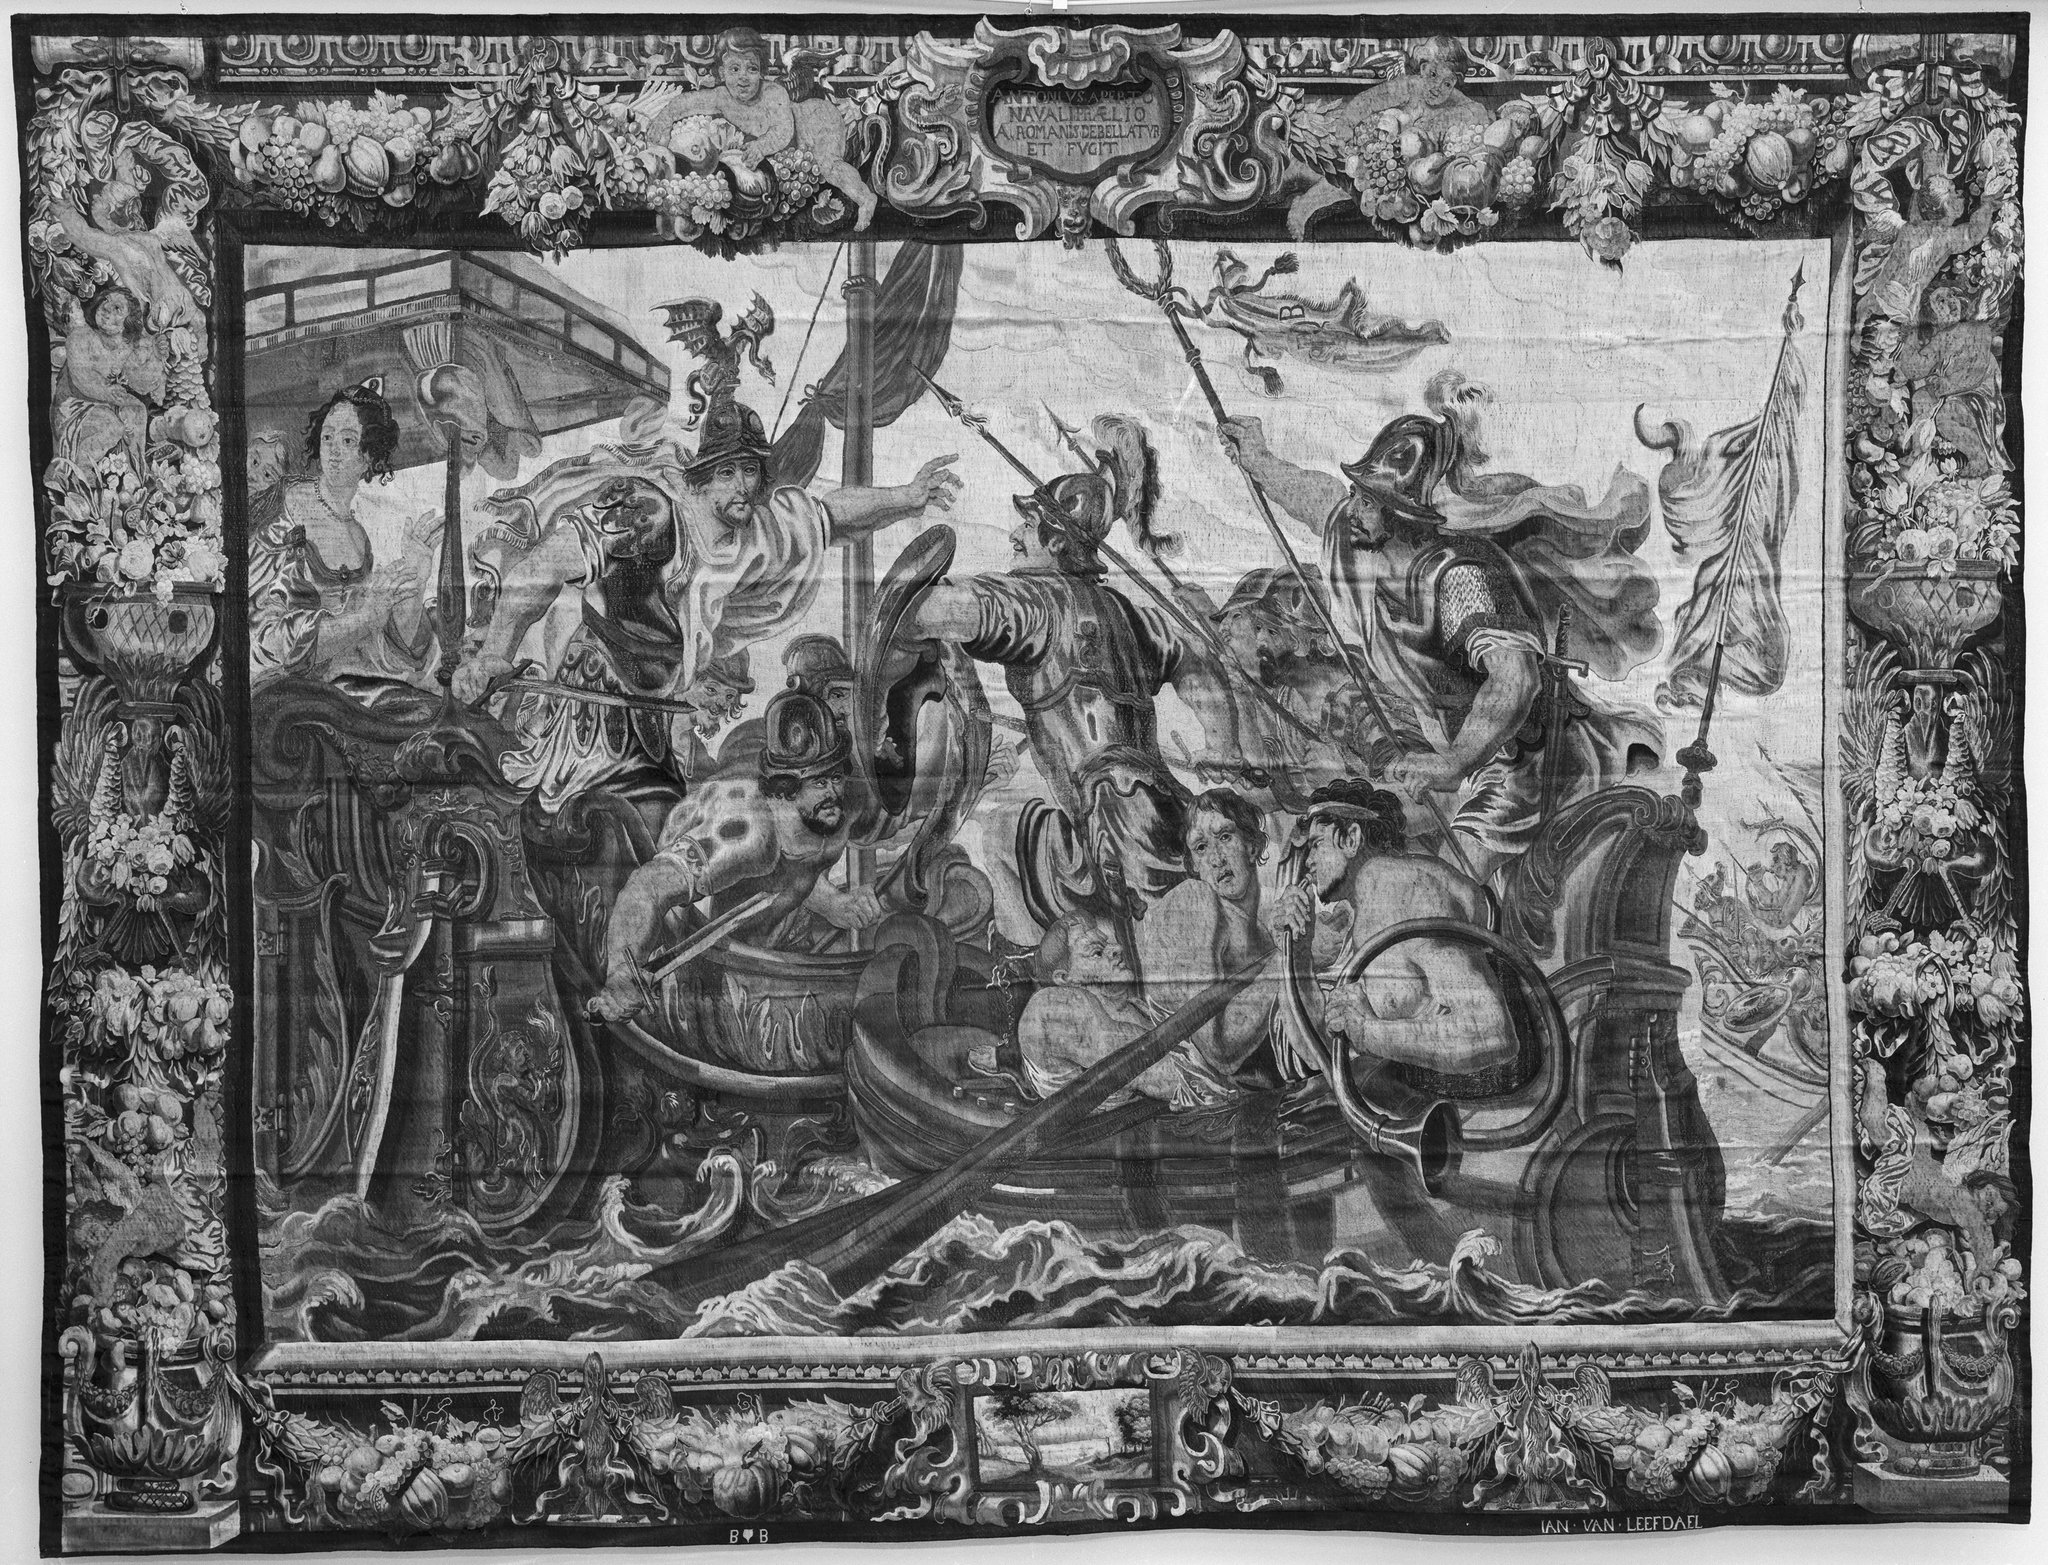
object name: tapestry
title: The Battle of Actium from a set of The Story of Antony and Cleopatra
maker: justus van egmont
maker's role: designer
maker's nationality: flemish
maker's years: 1601-1674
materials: silk, silver, silver gilt, thread, wool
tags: battles,soldiers,cleopatra,boats